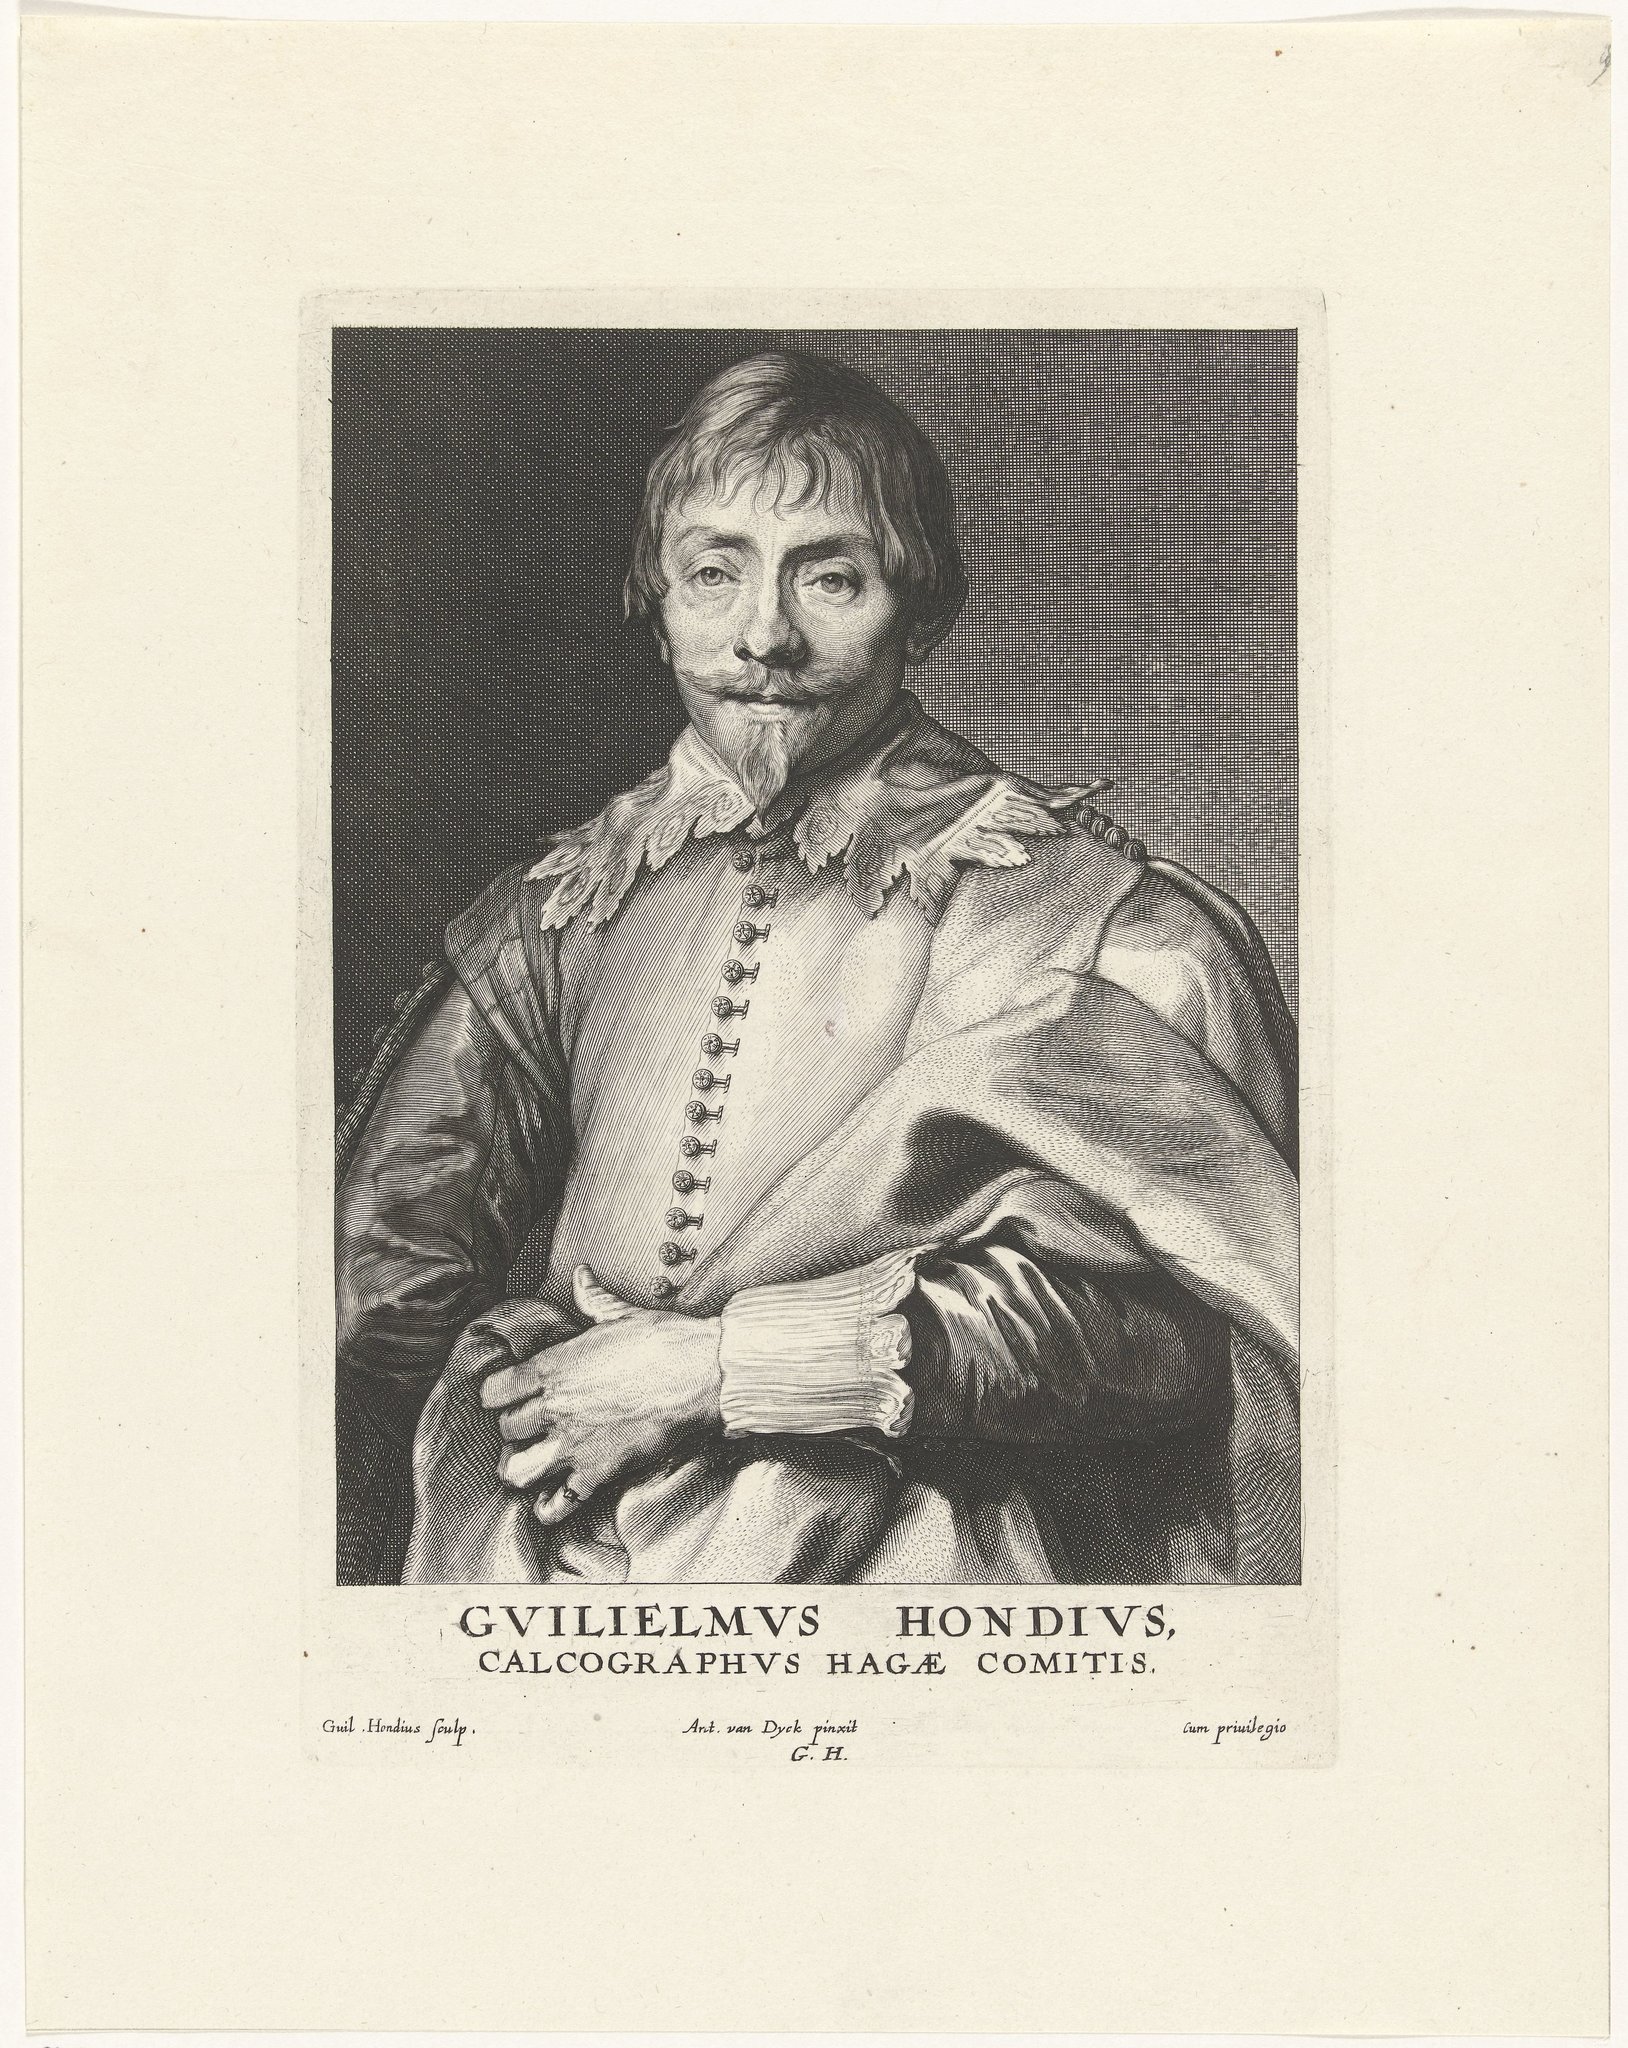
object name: print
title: Portret van Willem Hondius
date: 1608-1658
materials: paper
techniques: engraving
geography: antwerp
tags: the hague, print maker, willem hondius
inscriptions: collector's mark: Lugt 2166, collector's mark: Lugt 2760, collector's mark: Lugt 2228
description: Behoort tot de Verzameling Gerritsen, kunstenaarsportretten